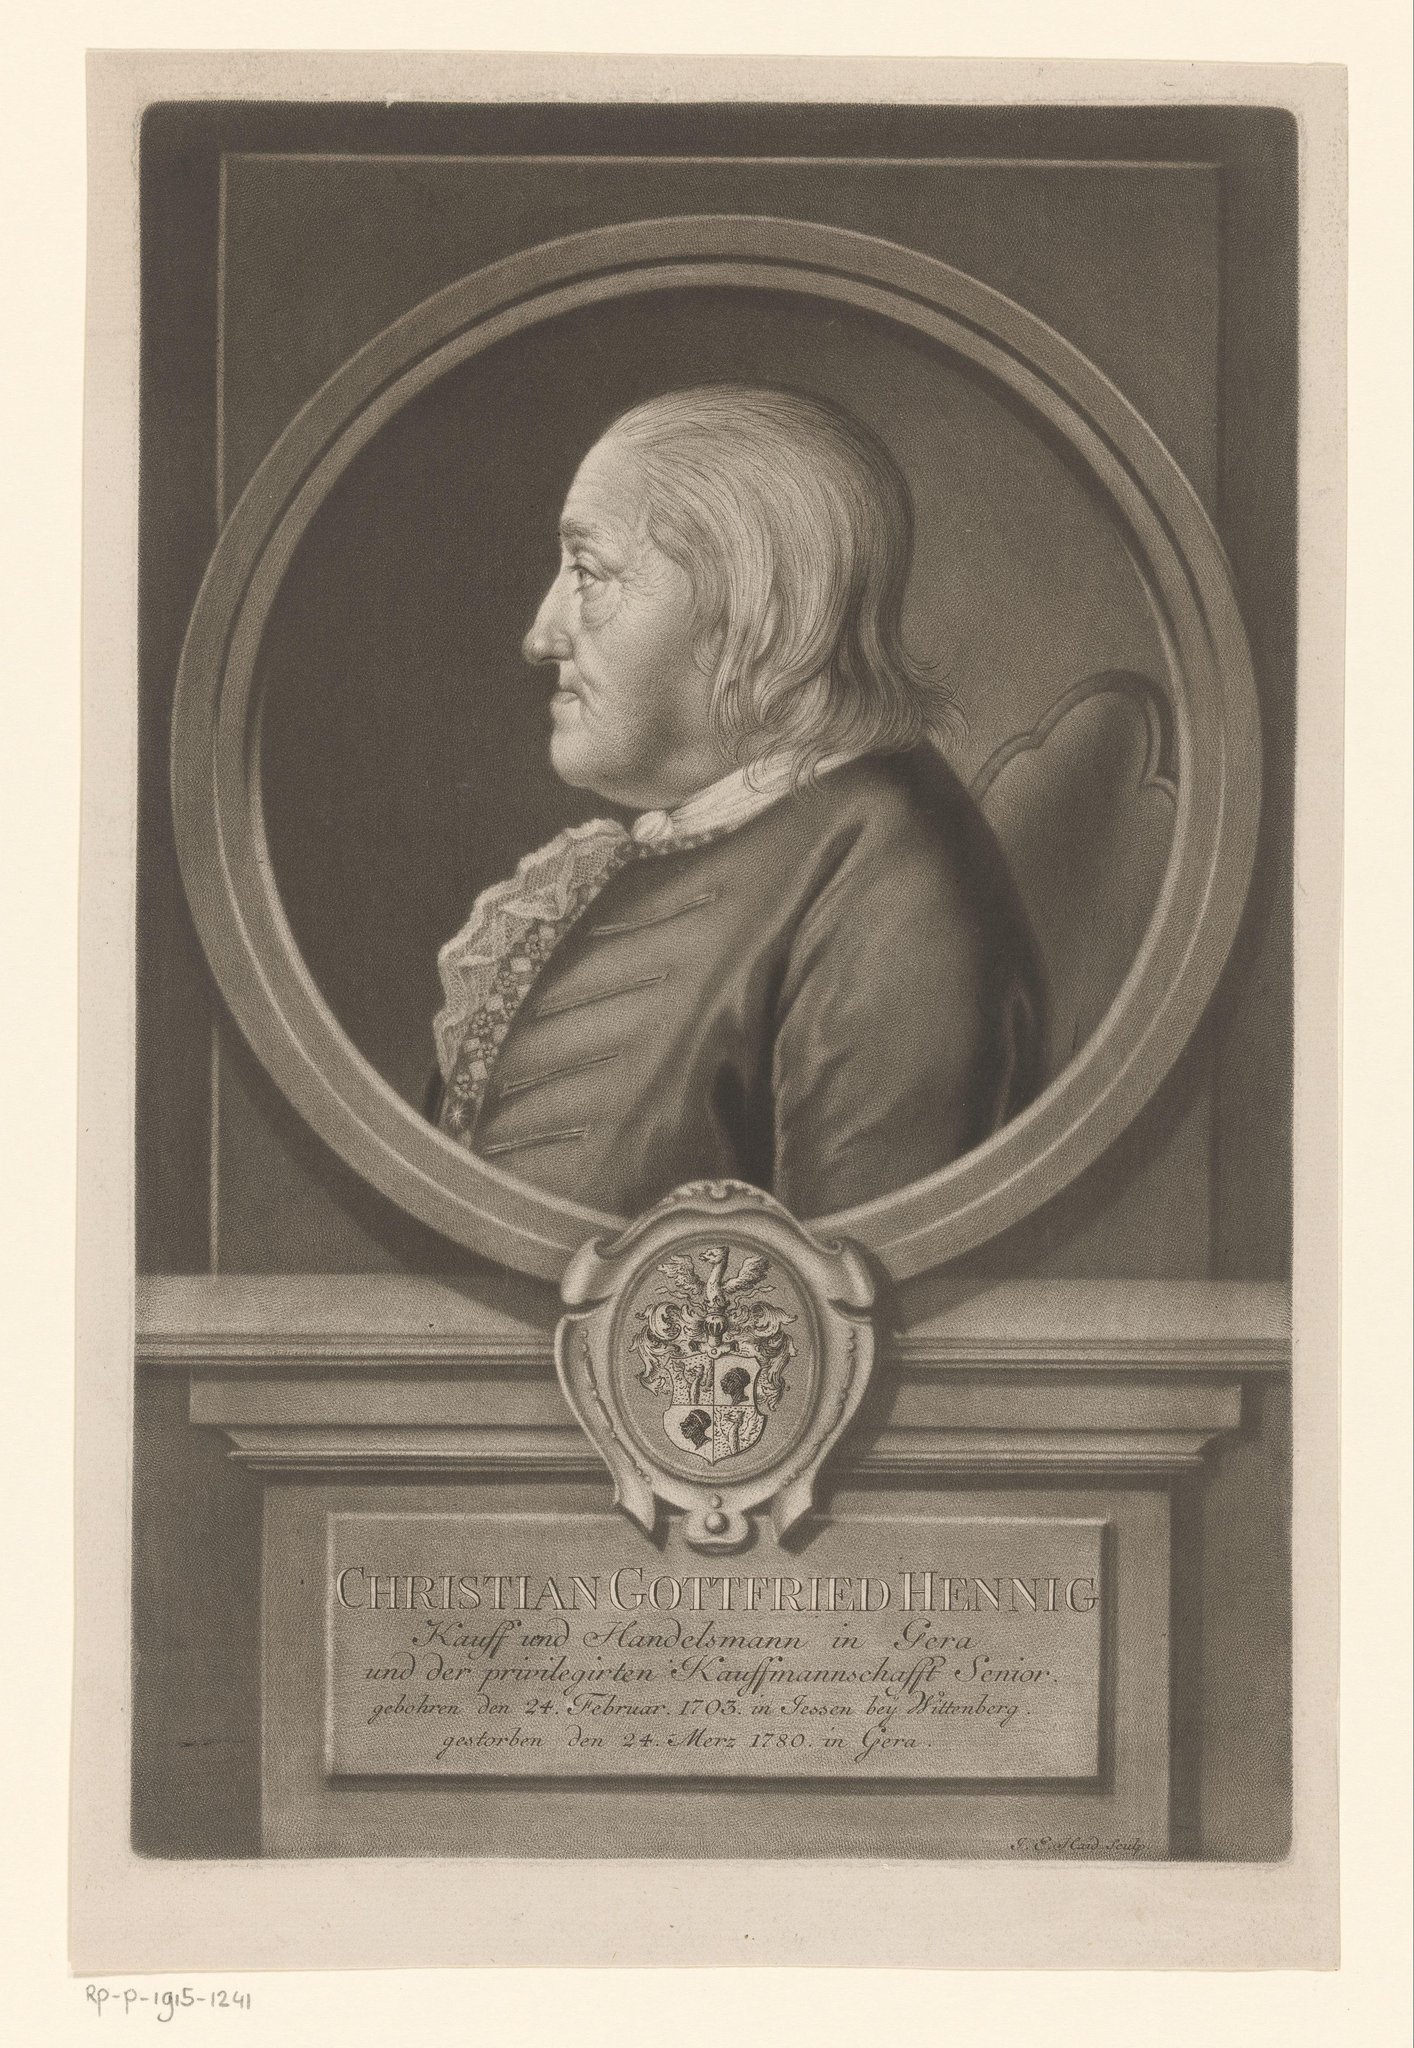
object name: print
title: Portret van Christian Gottfried Hennig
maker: johann elias haid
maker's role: print maker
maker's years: 1739-1809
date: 1780-1809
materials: paper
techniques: mezzotint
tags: historical persons, armorial bearing, heraldry, merchant, salesman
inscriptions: collector's mark: Lugt 2228